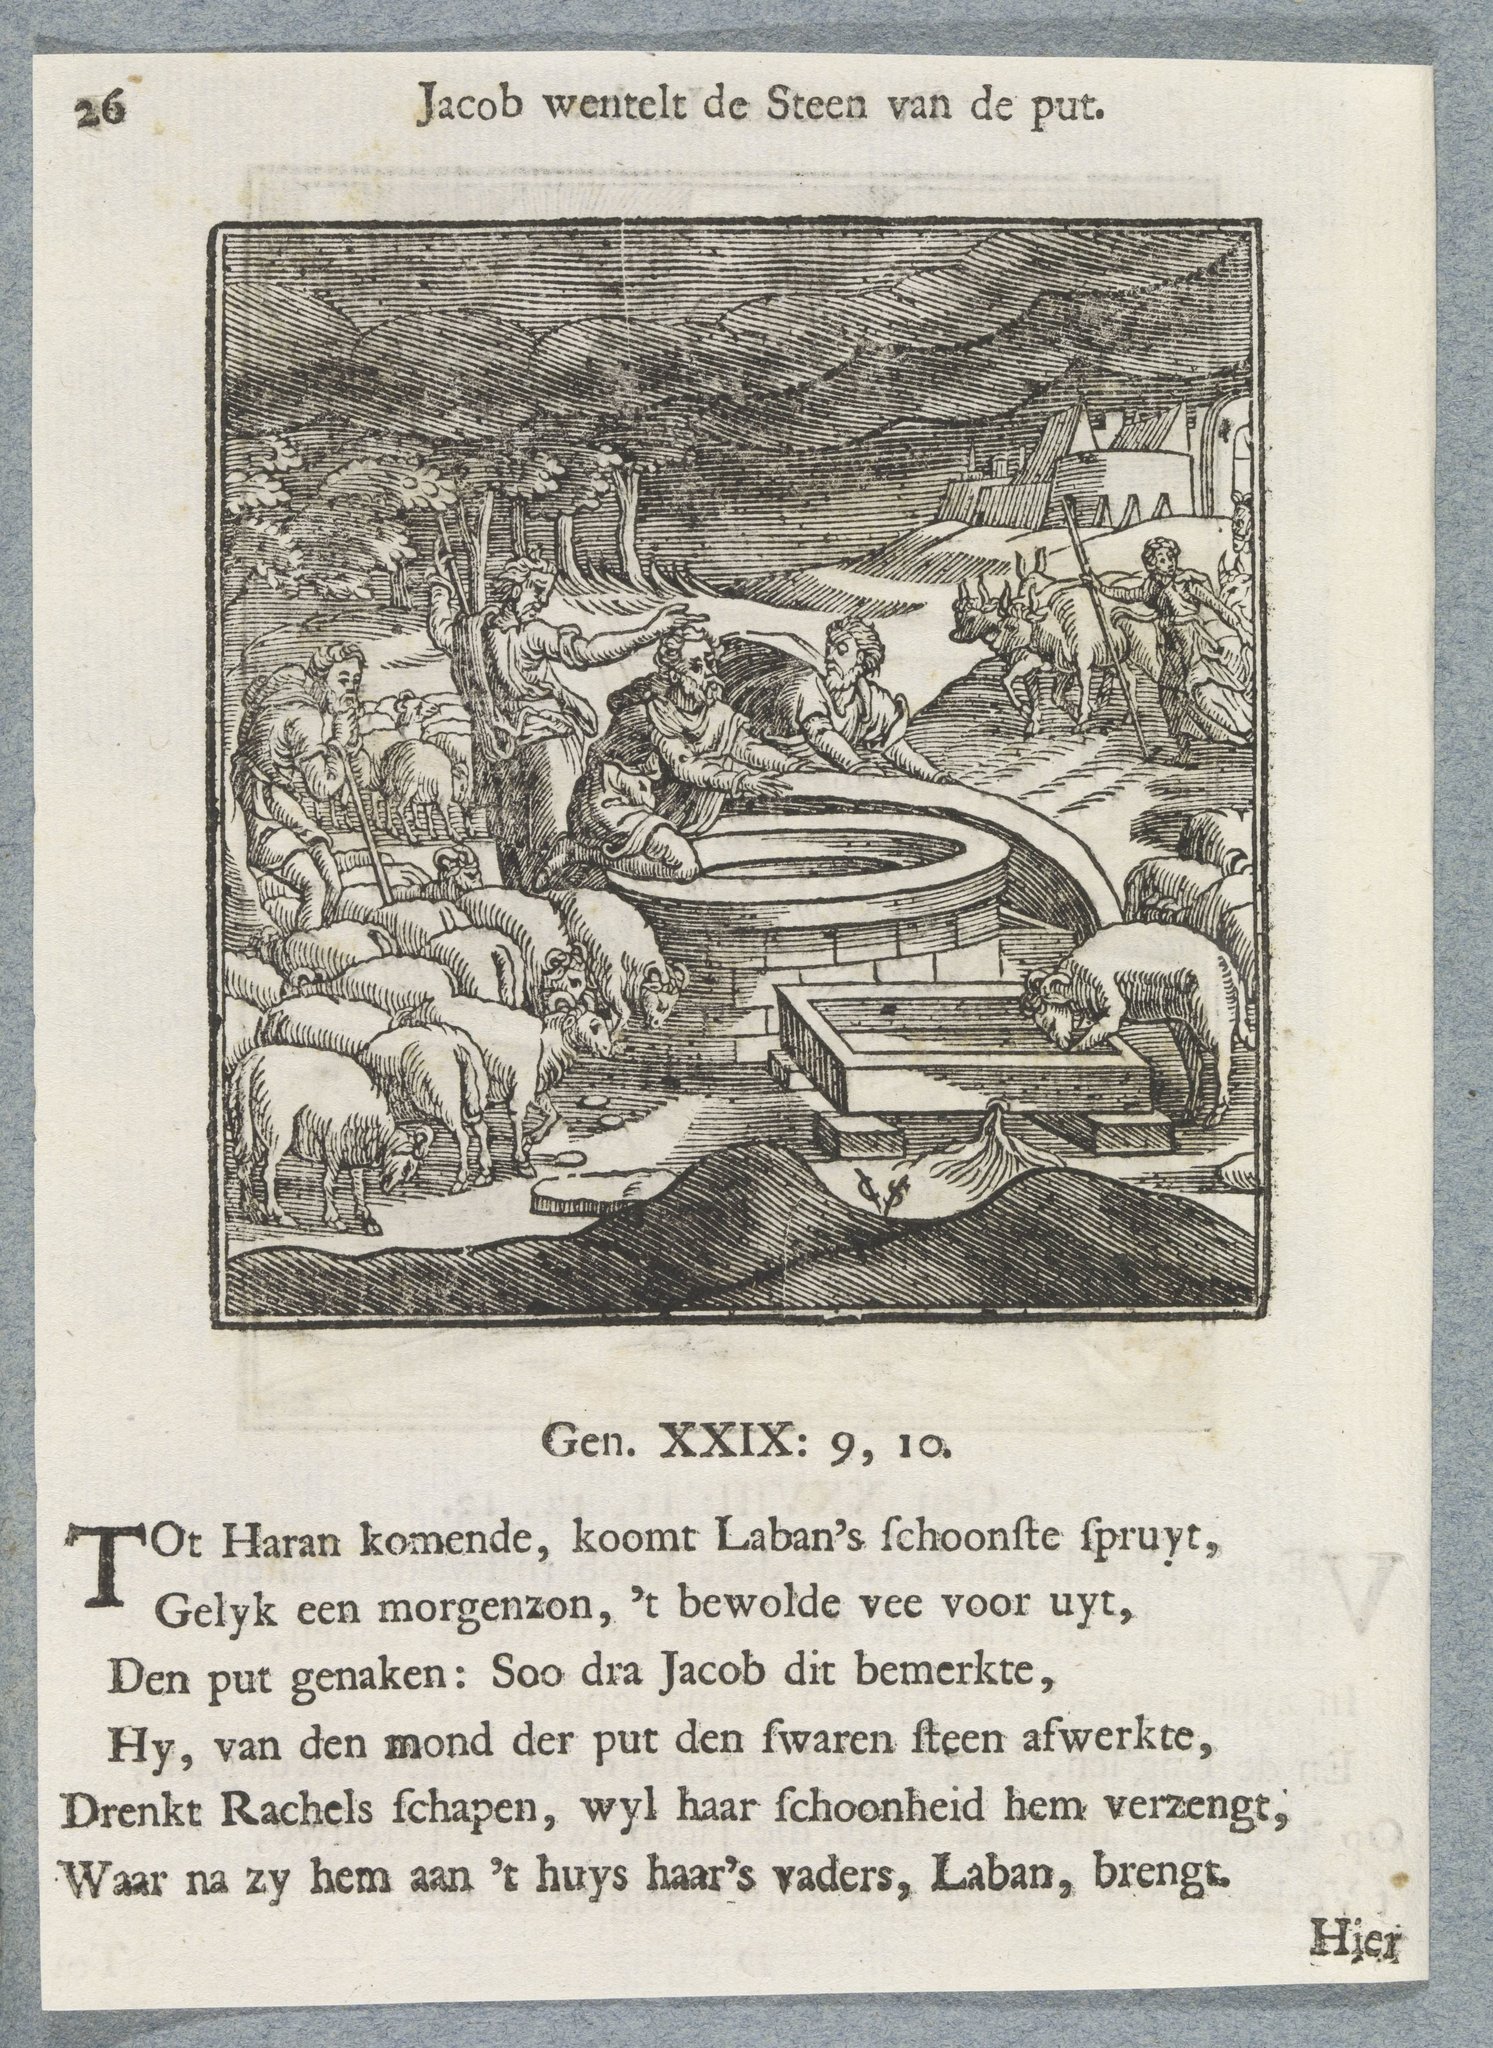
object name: album leaf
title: Jakob tilt de steen van de put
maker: jan klooster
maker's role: bookseller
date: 1645-1646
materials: paper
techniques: letterpress printing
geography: amsterdam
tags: jacob moves the stone which covers the opening of the well and waters rachel's sheep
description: De prent is afkomstig uit: Bybels Lusthof. Amsterdam, J. Klooster, 1740. De prent werd gemaakt voor de uitgaven van P.J. Paets uit Amsterdam. Ze komt in ieder geval voor in: Bibels Tresoor ofte der zielen lusthof. Amsterdam, P.J. Paets, 1646. Mogelijk staat ze ook in: Historien ende Prophetien. [Amsterdam], P.J. Paets, 1645.